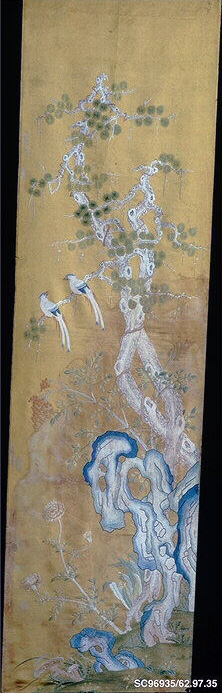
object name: panel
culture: chinese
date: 1701-1800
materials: paint, silk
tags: birds,flowers